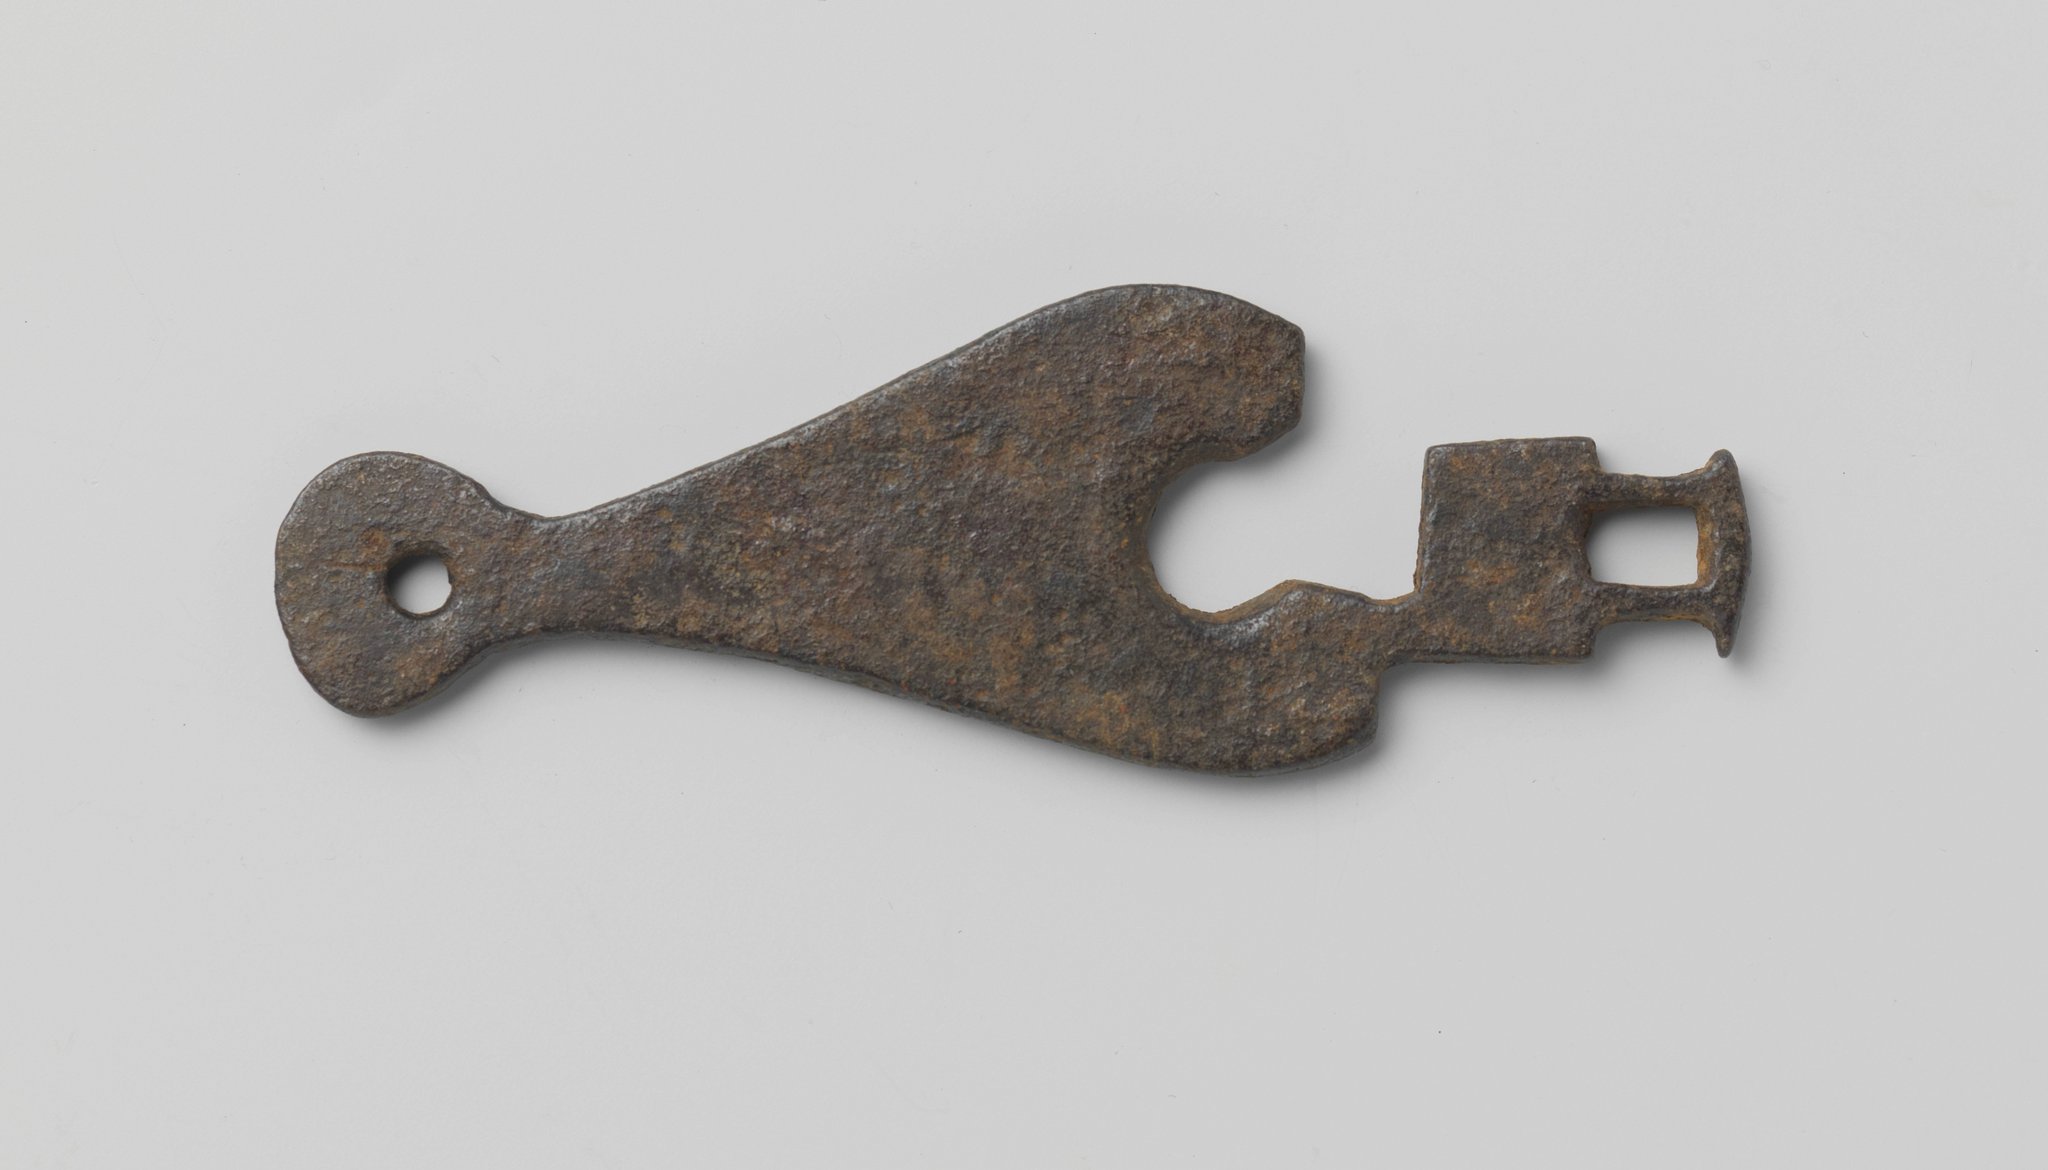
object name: schuifsleutel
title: Key latch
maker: Anonymous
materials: iron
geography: spain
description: Schuifsleutel behorende bij een hangslot.